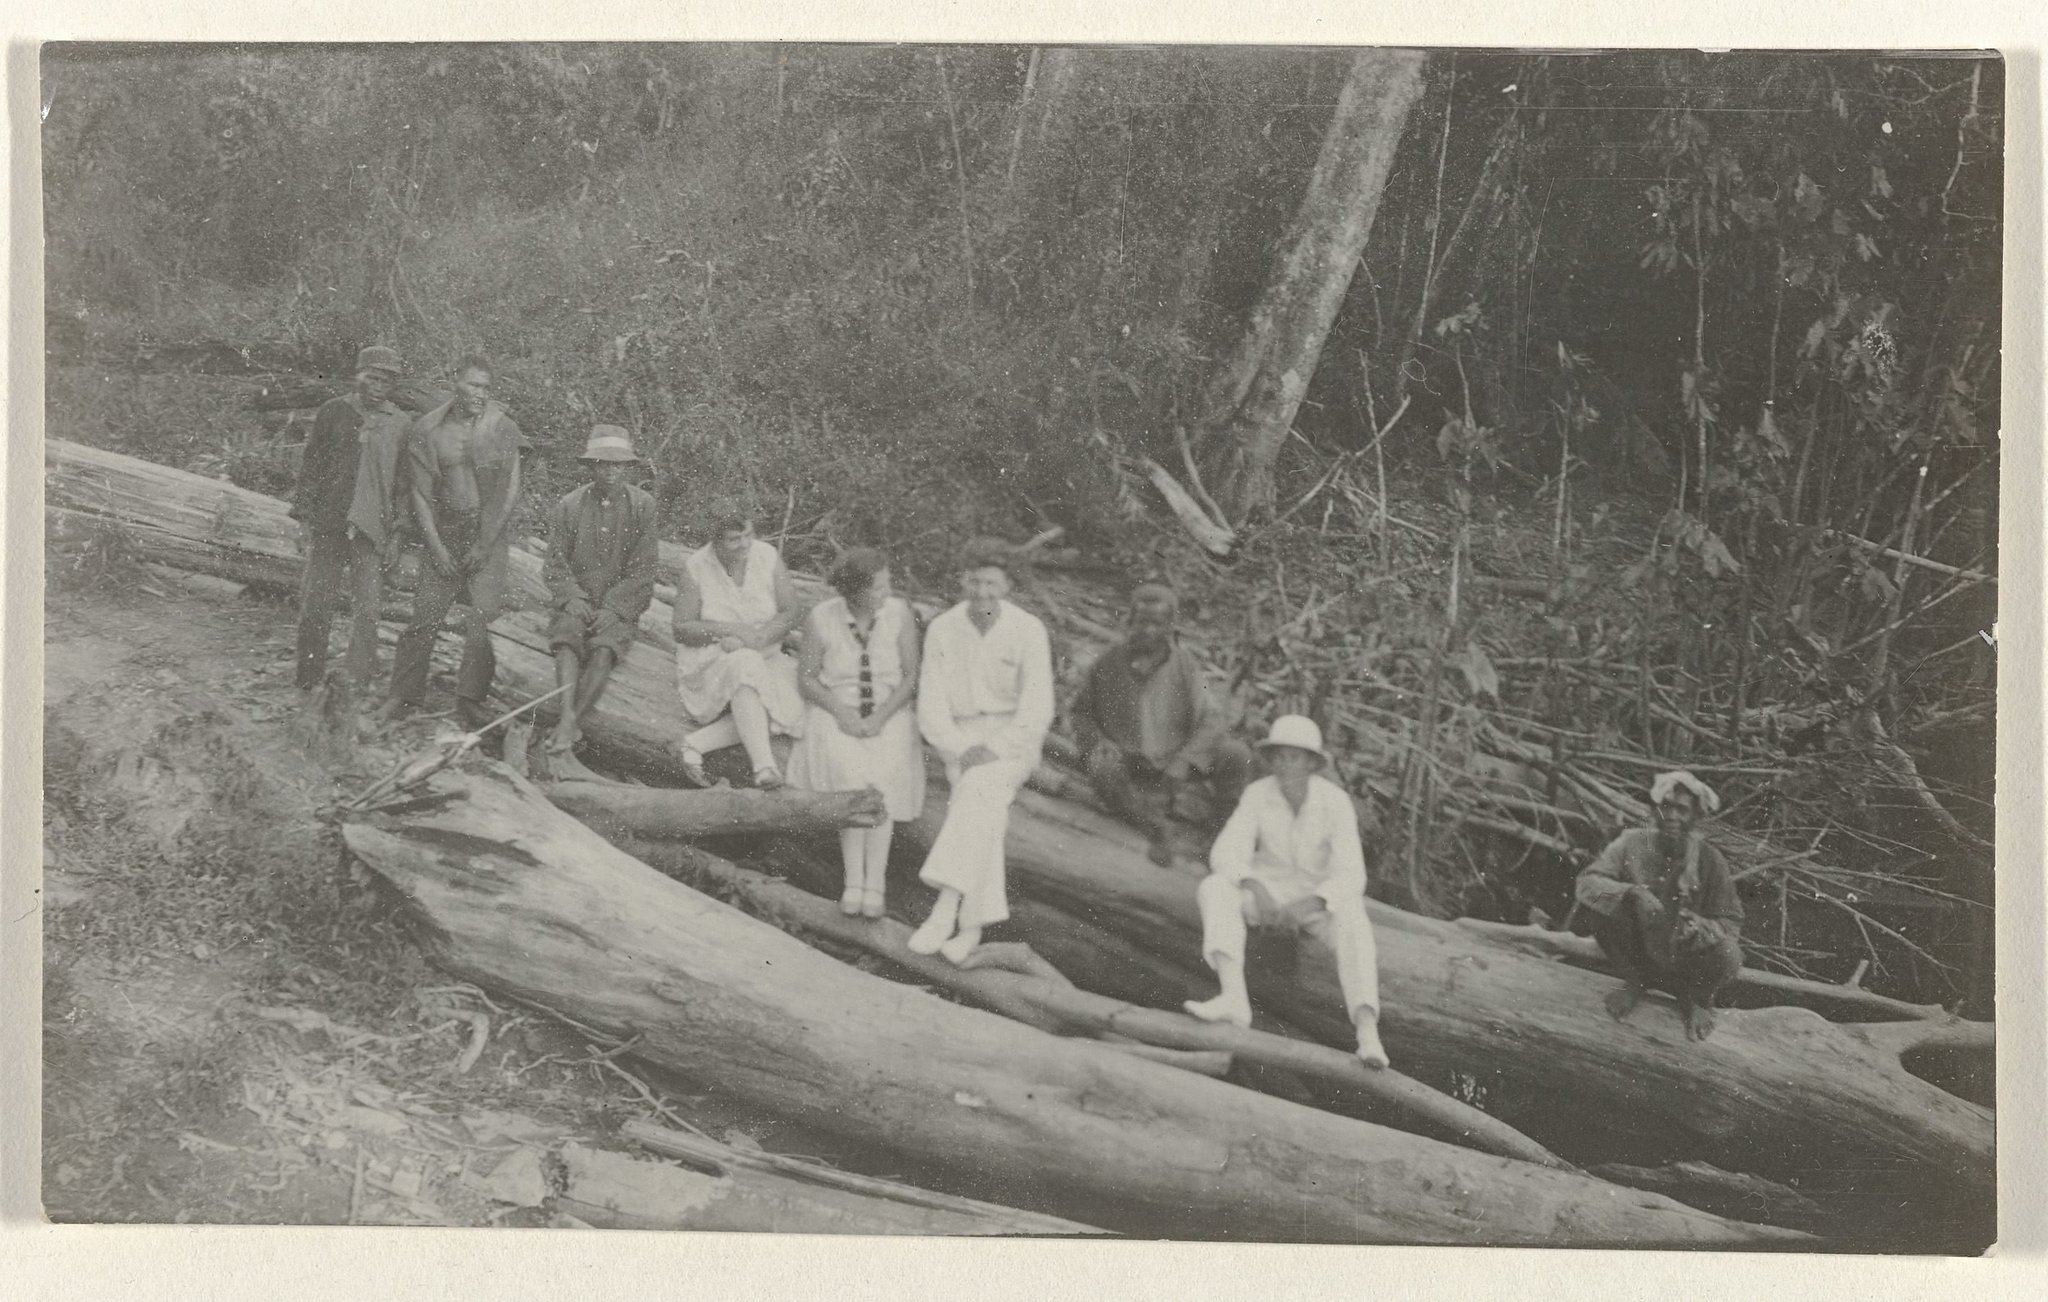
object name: photograph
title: Groepsportret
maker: Anonymous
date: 1929-1930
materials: photographic support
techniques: photography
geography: suriname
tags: albina, moengo